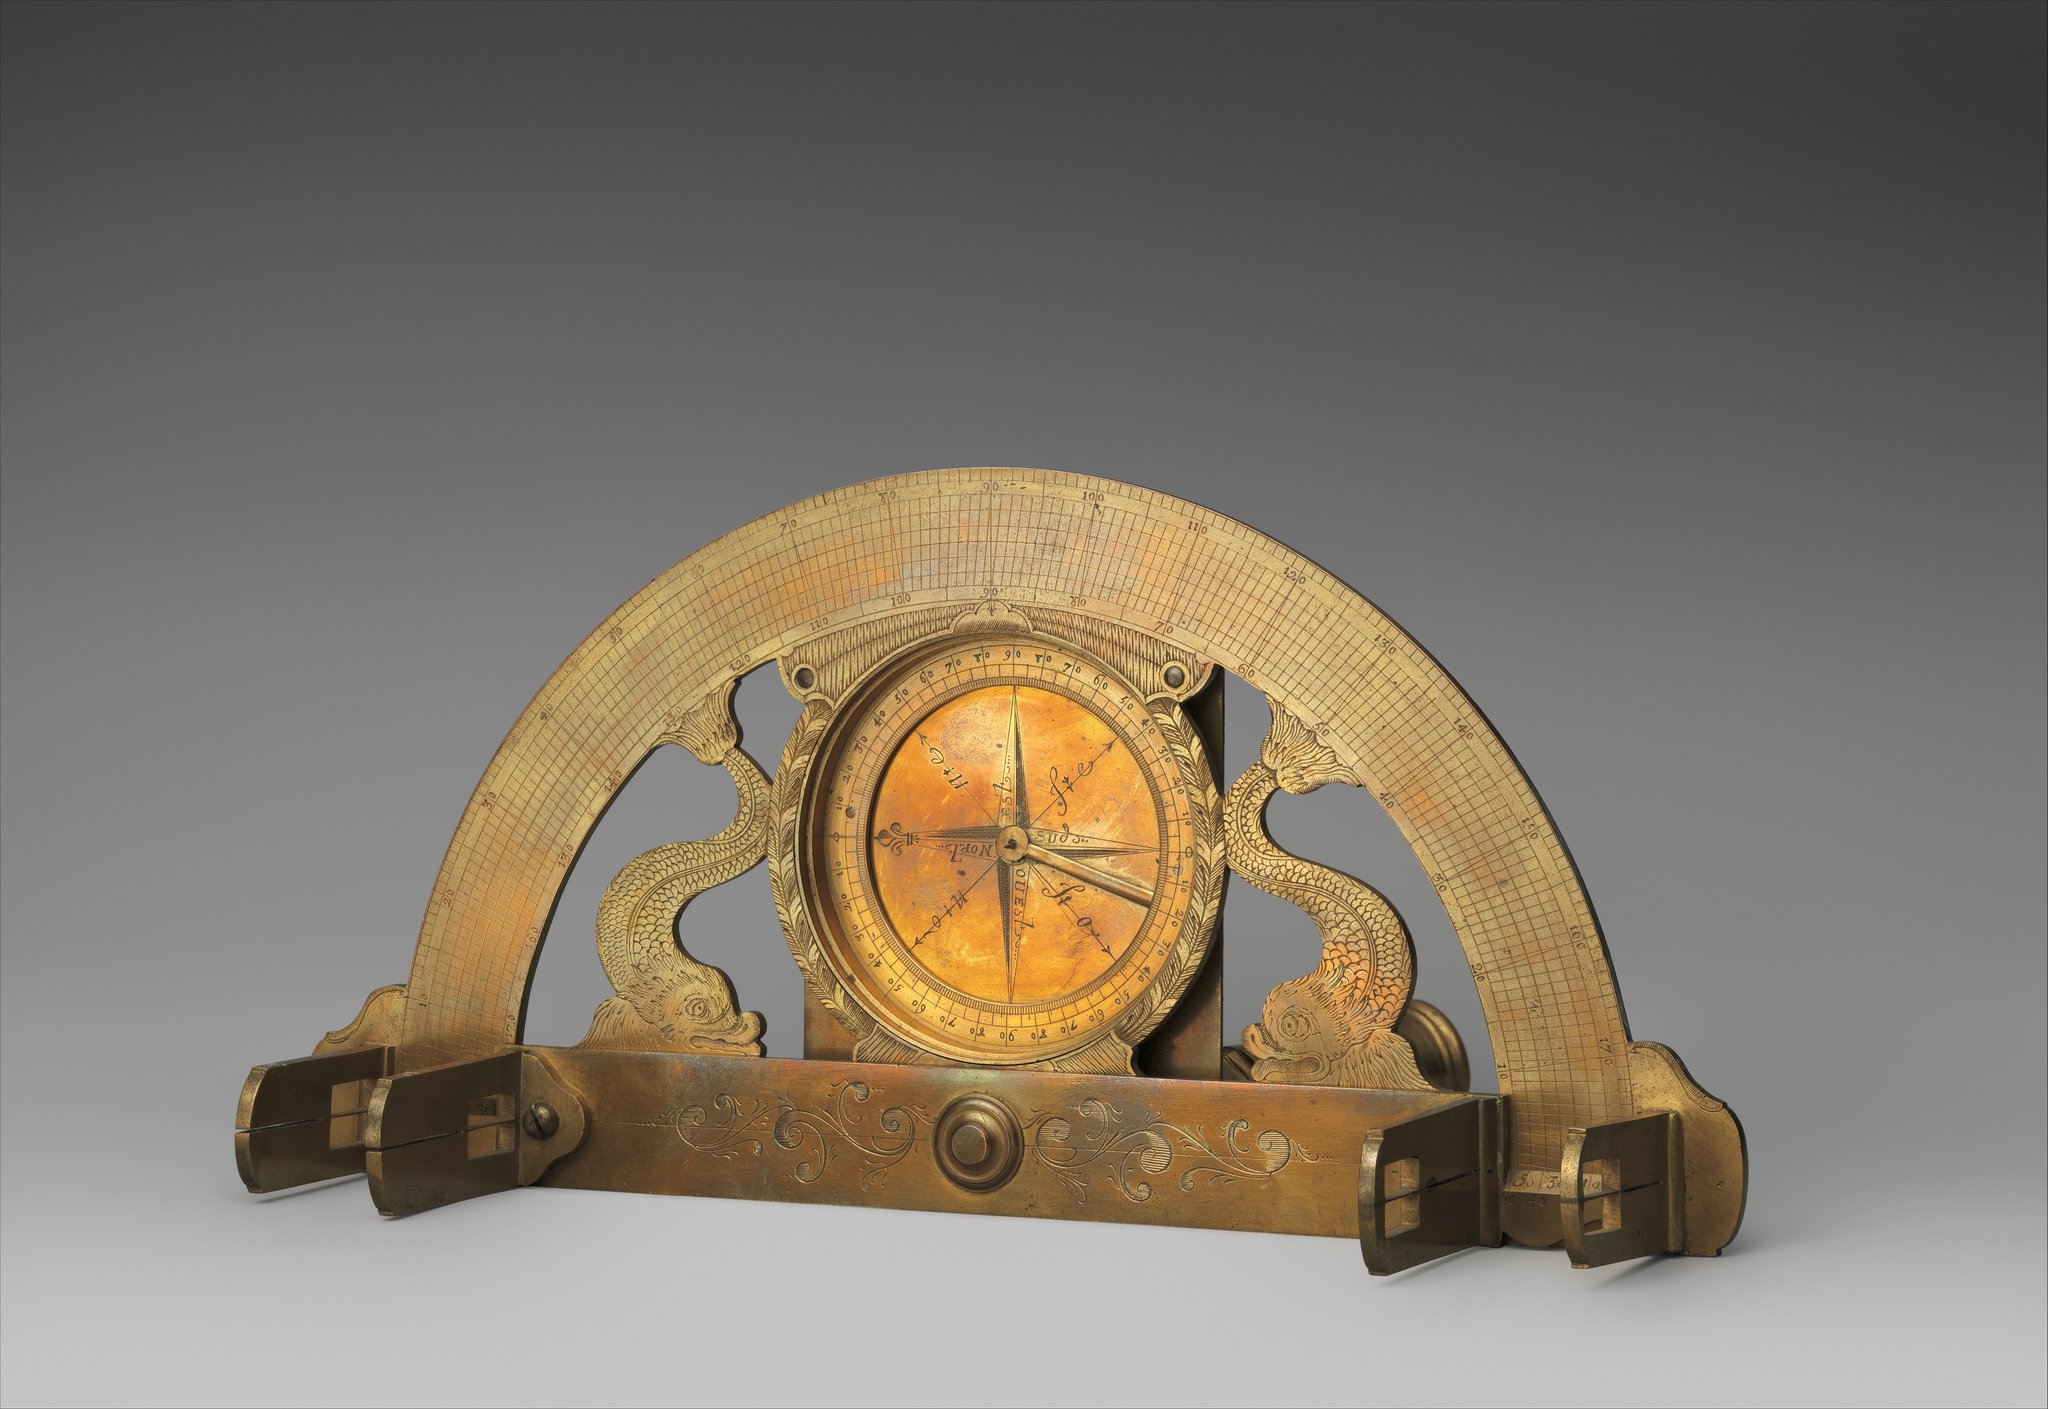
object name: graphometer or semicircle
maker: michael butterfield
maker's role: maker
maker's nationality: english, active in paris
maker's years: 1635-1724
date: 1667-1733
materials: brass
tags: fish